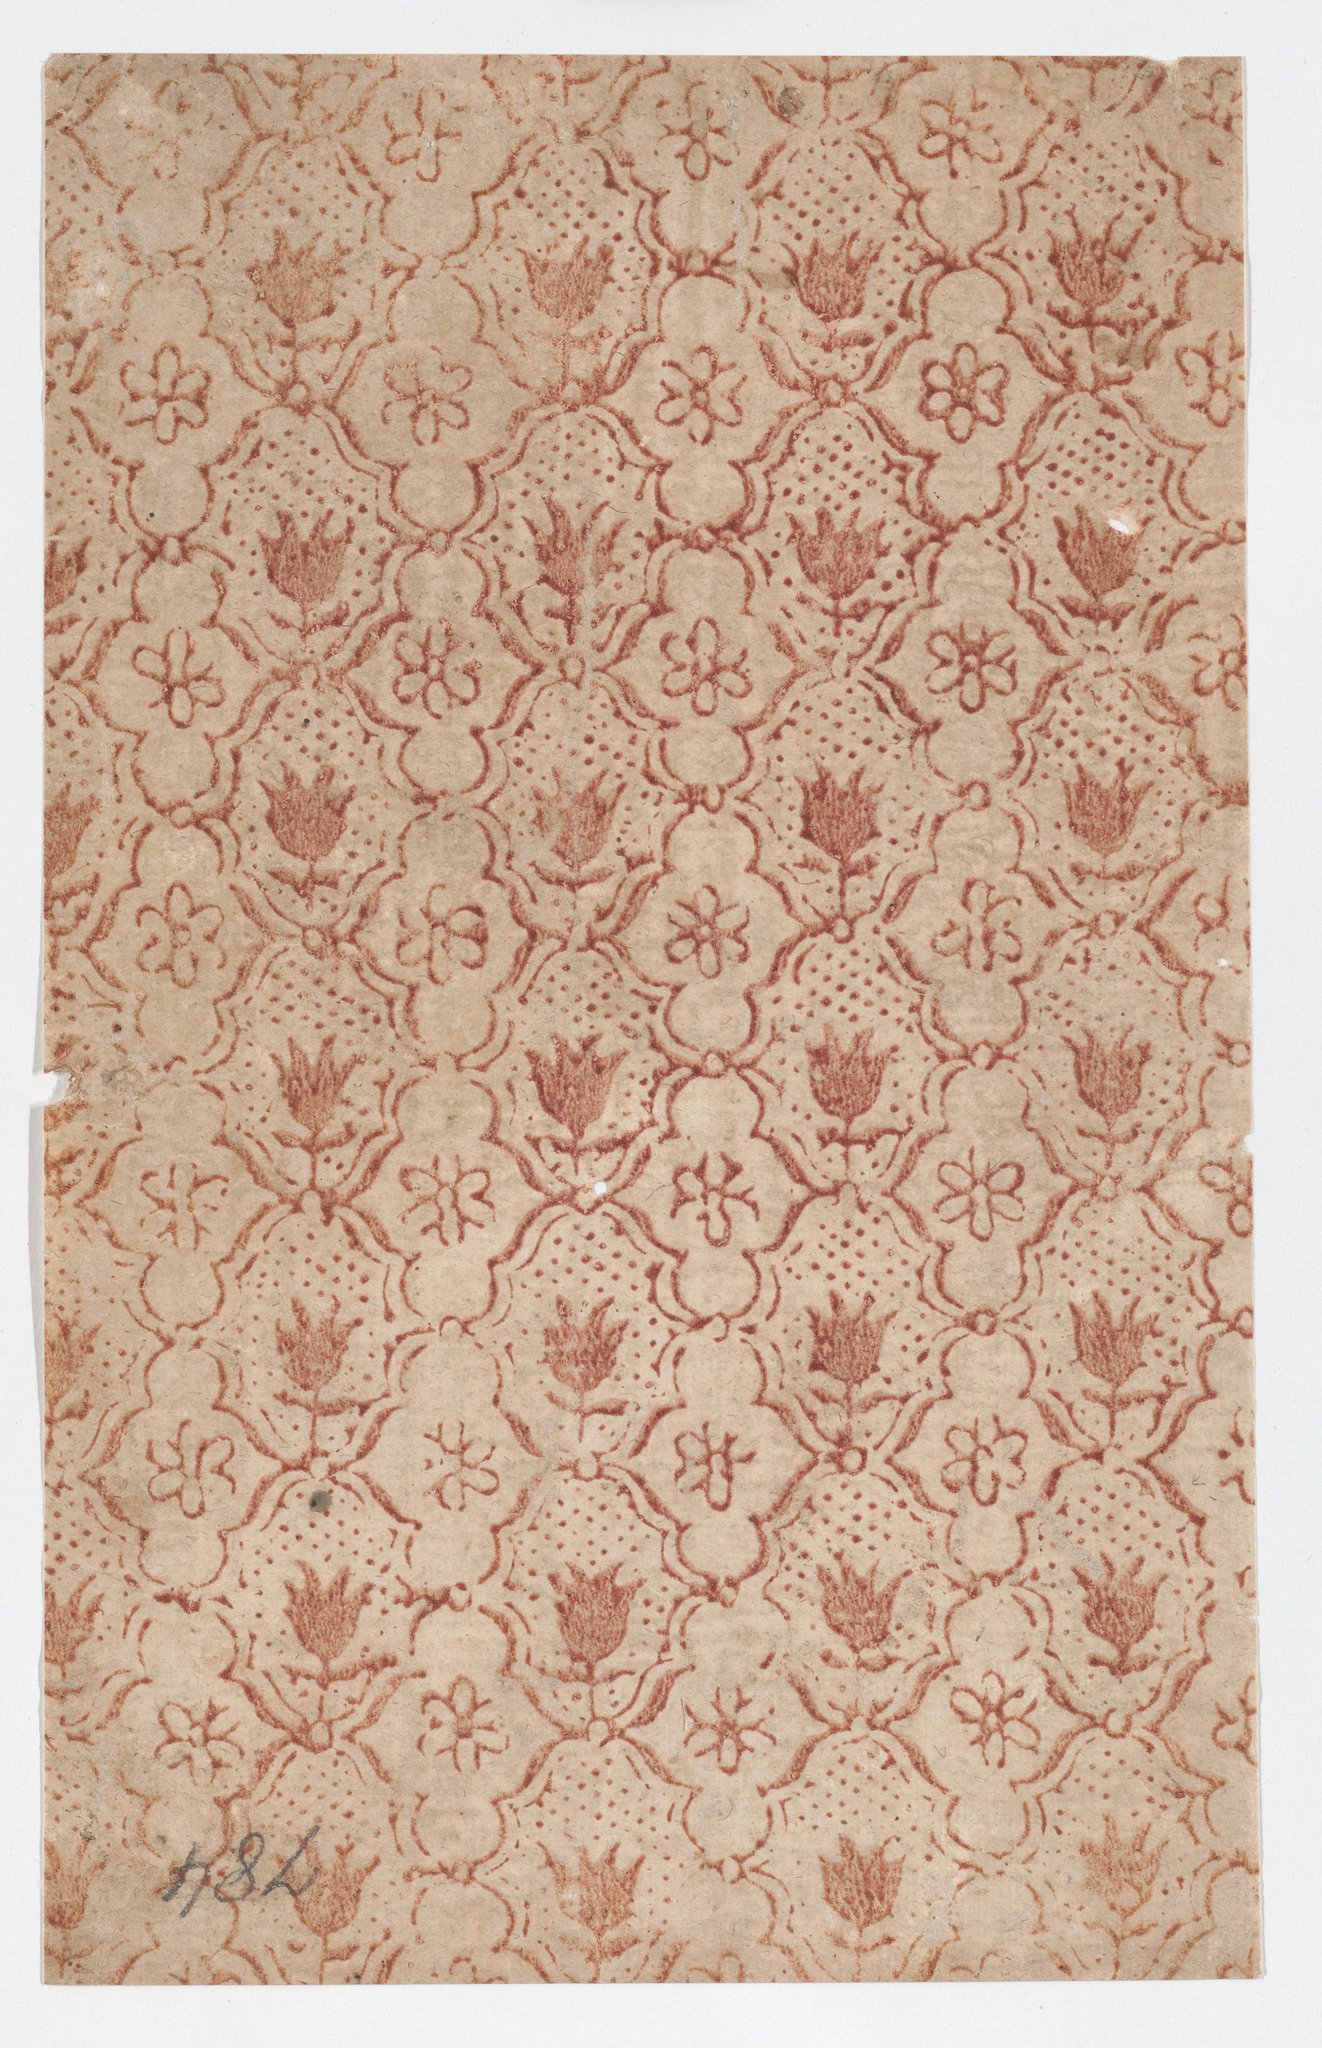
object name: print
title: Sheet with overall lattice pattern with flowers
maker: Anonymous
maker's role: artist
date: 1801-1900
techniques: relief print